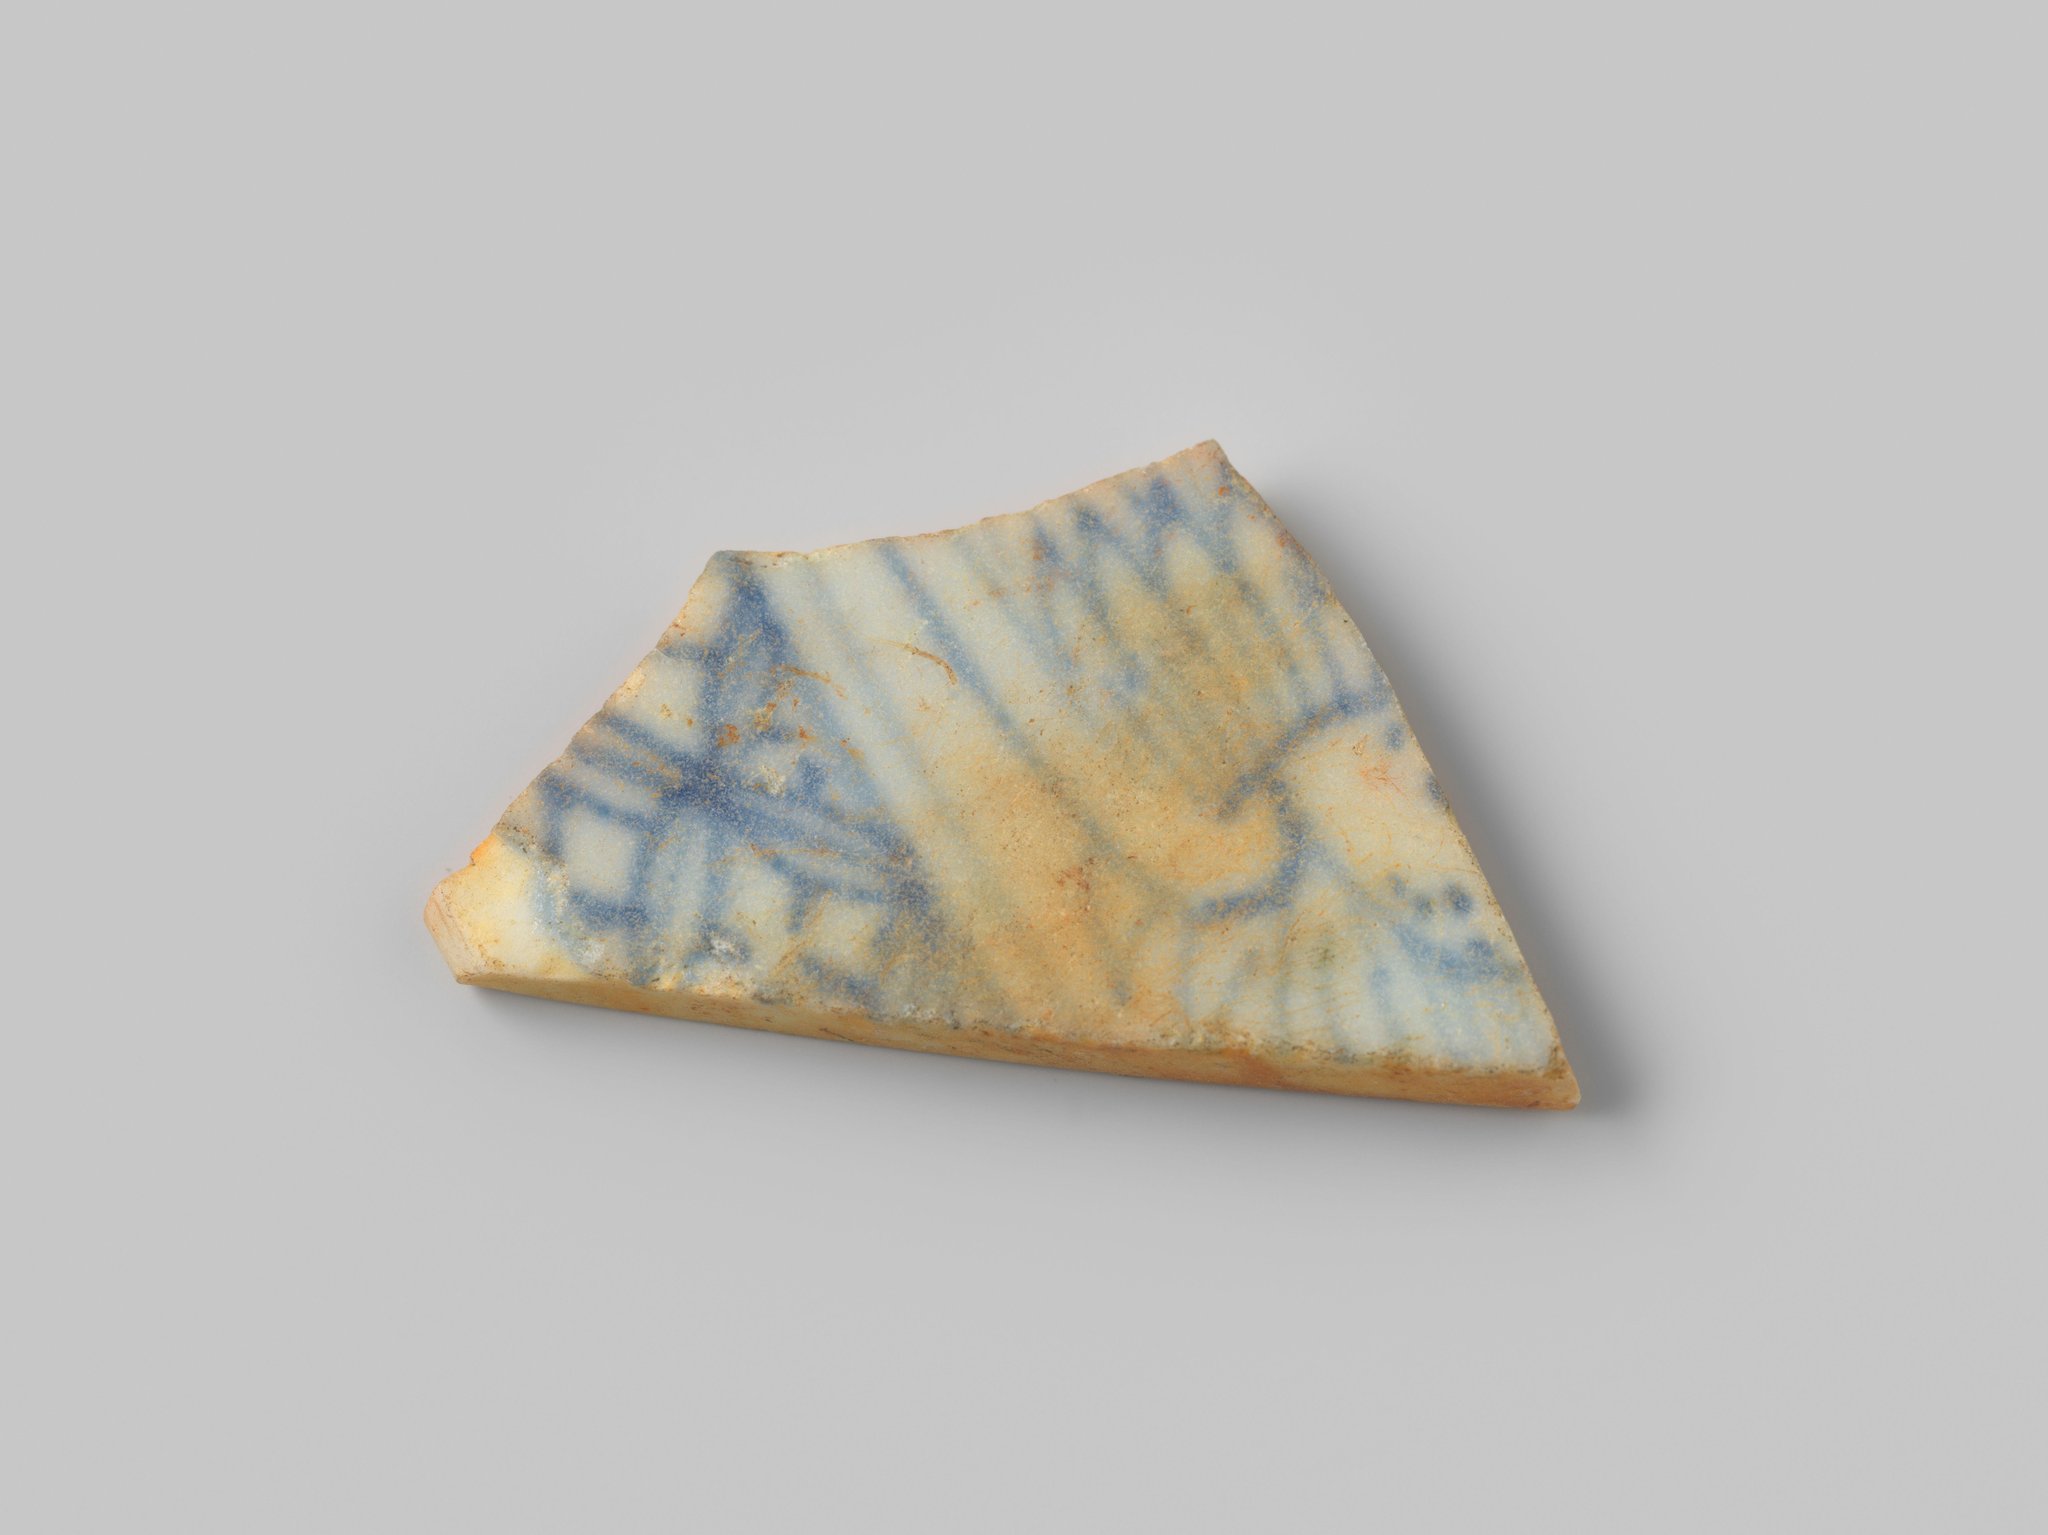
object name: sherd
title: Scherf van een bord uit het wrak van de Oost-Indiëvaarder Hollandia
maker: Anonymous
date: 1700-1743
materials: porcelain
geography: netherlands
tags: verenigde oostindische compagnie, hollandia (schip), annet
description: Porcelain, plate, type 1; fragm of rim, sim NG 1980-27H1662.